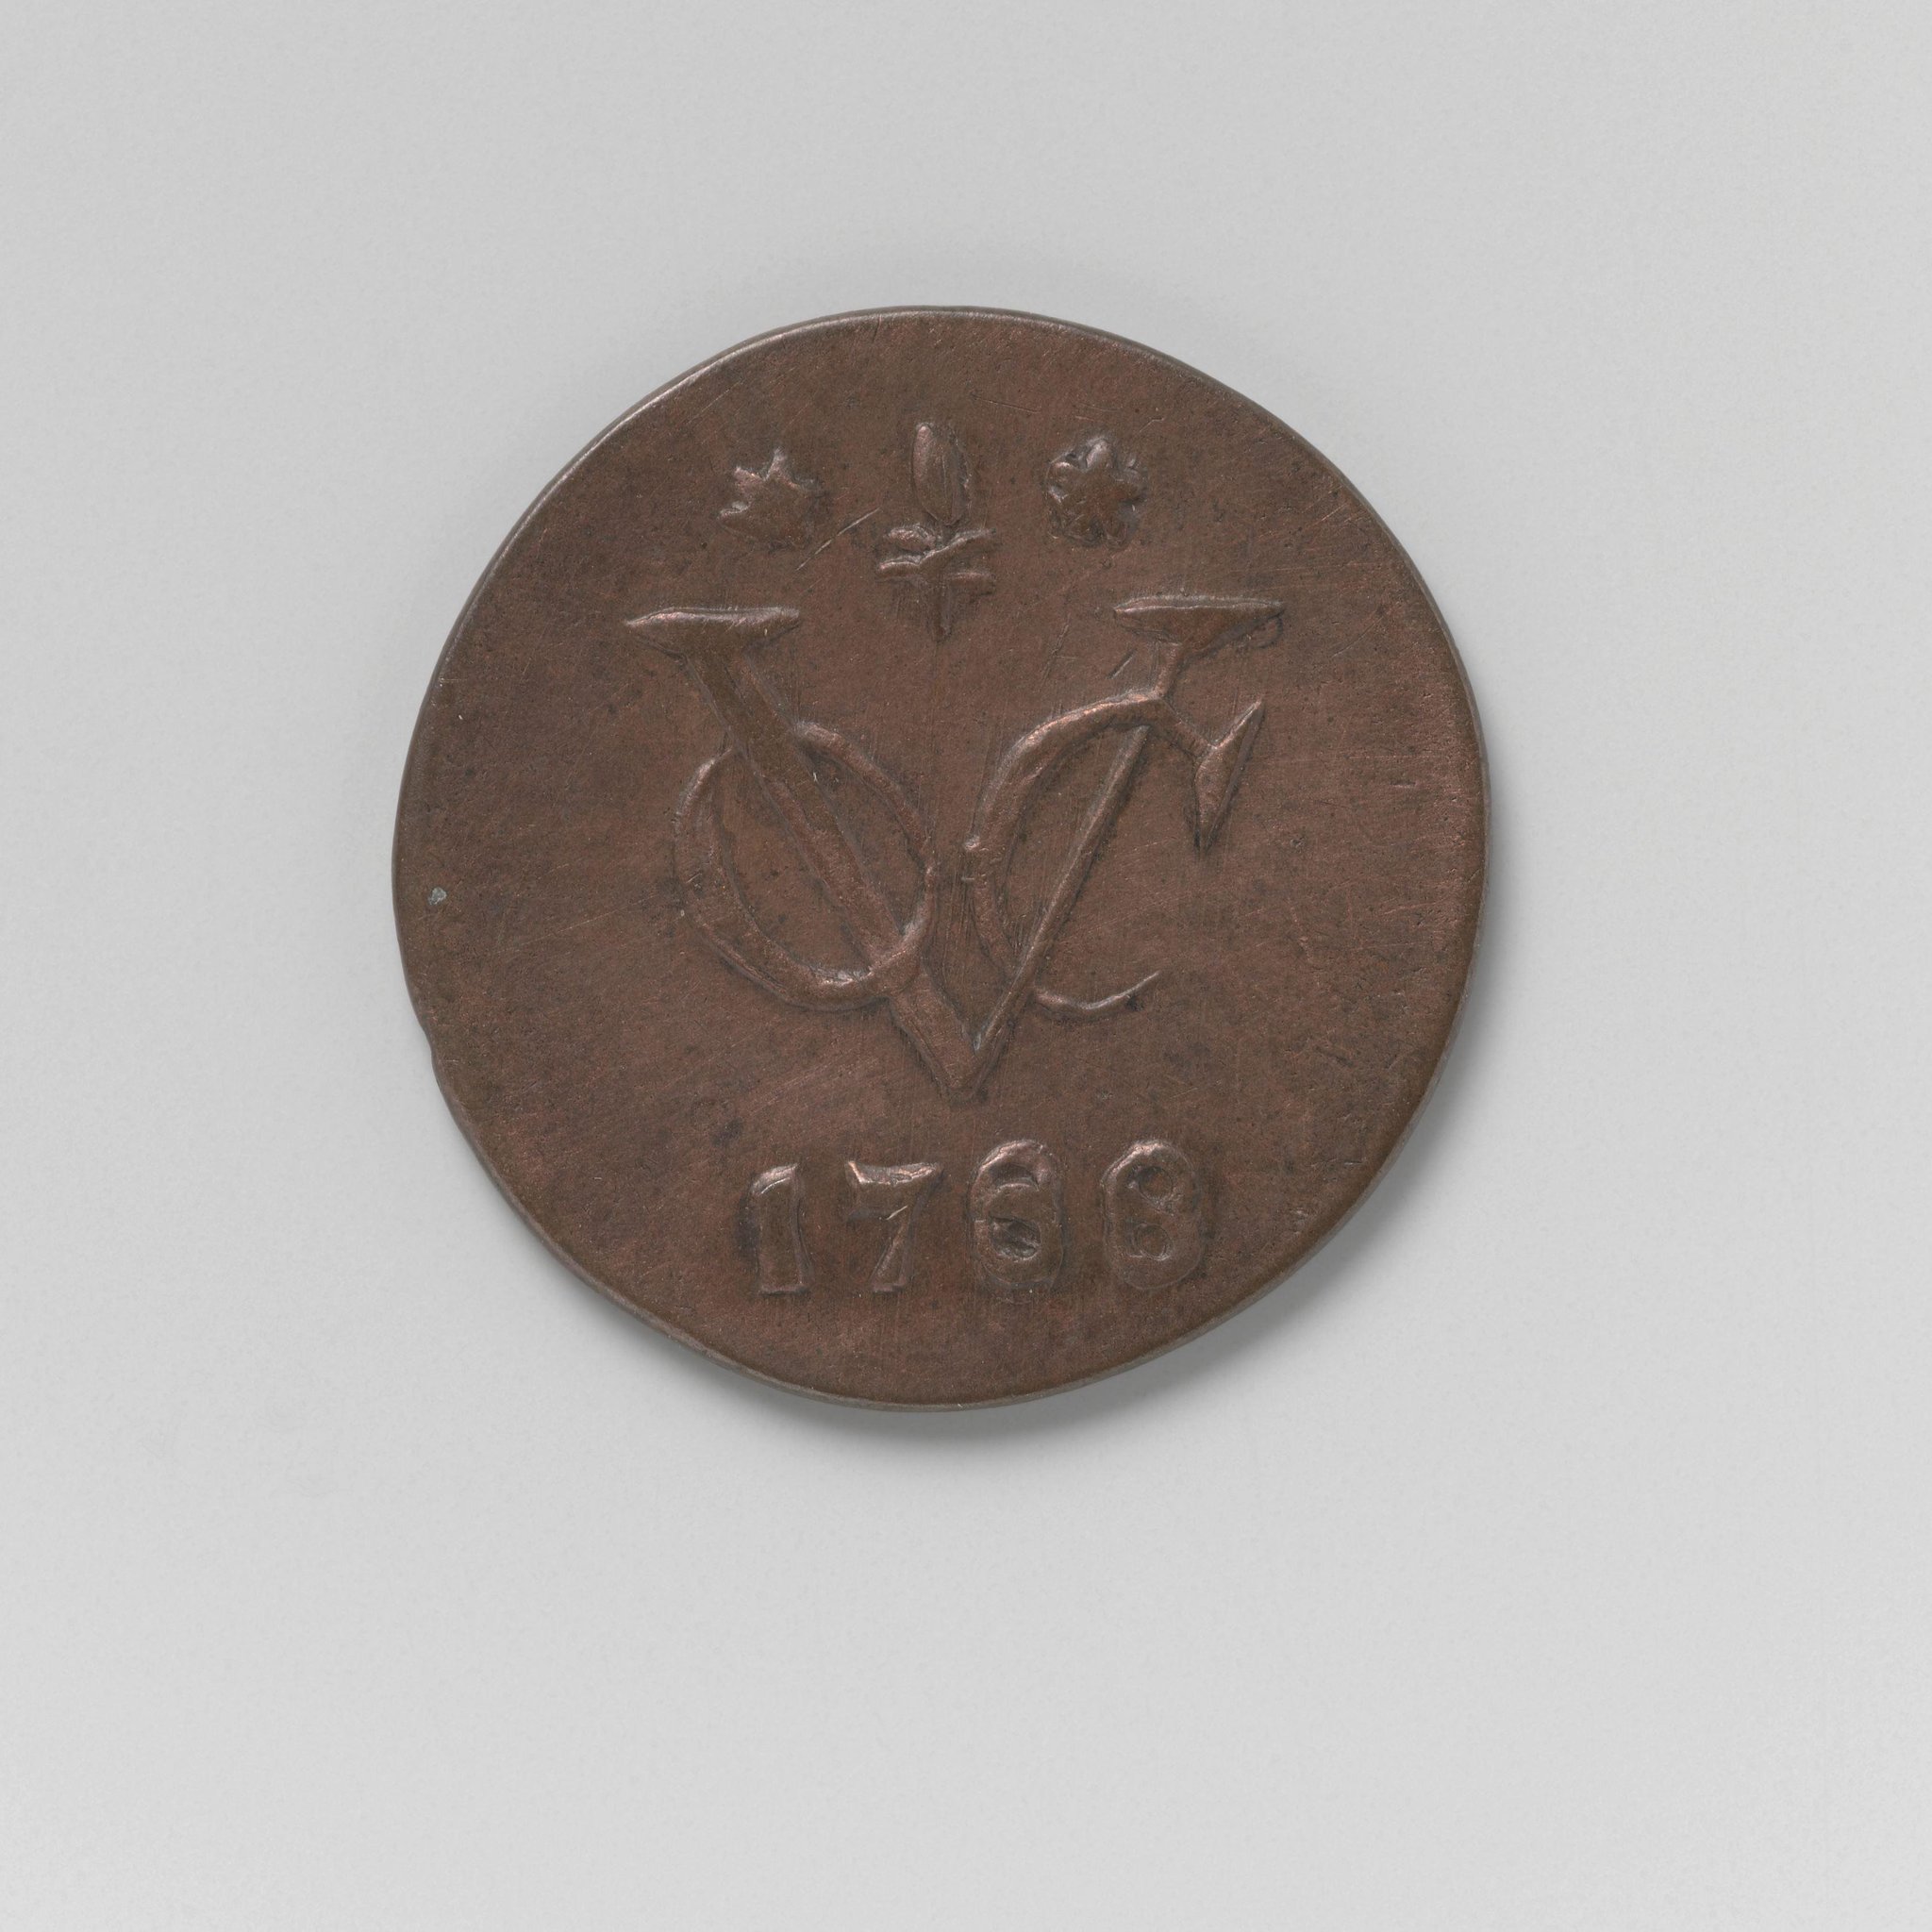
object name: coin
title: VOC, ½ duit Gelderland,1788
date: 1788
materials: copper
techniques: striking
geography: harderwijk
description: Koperen munt. Voorzijde: tussen wapenspreuk gekroond wapenschild van Gelderland. Keerzijde: monogram van de VOC, waarboven muntmeesterteken en waaronder jaartal. Gladde rand.